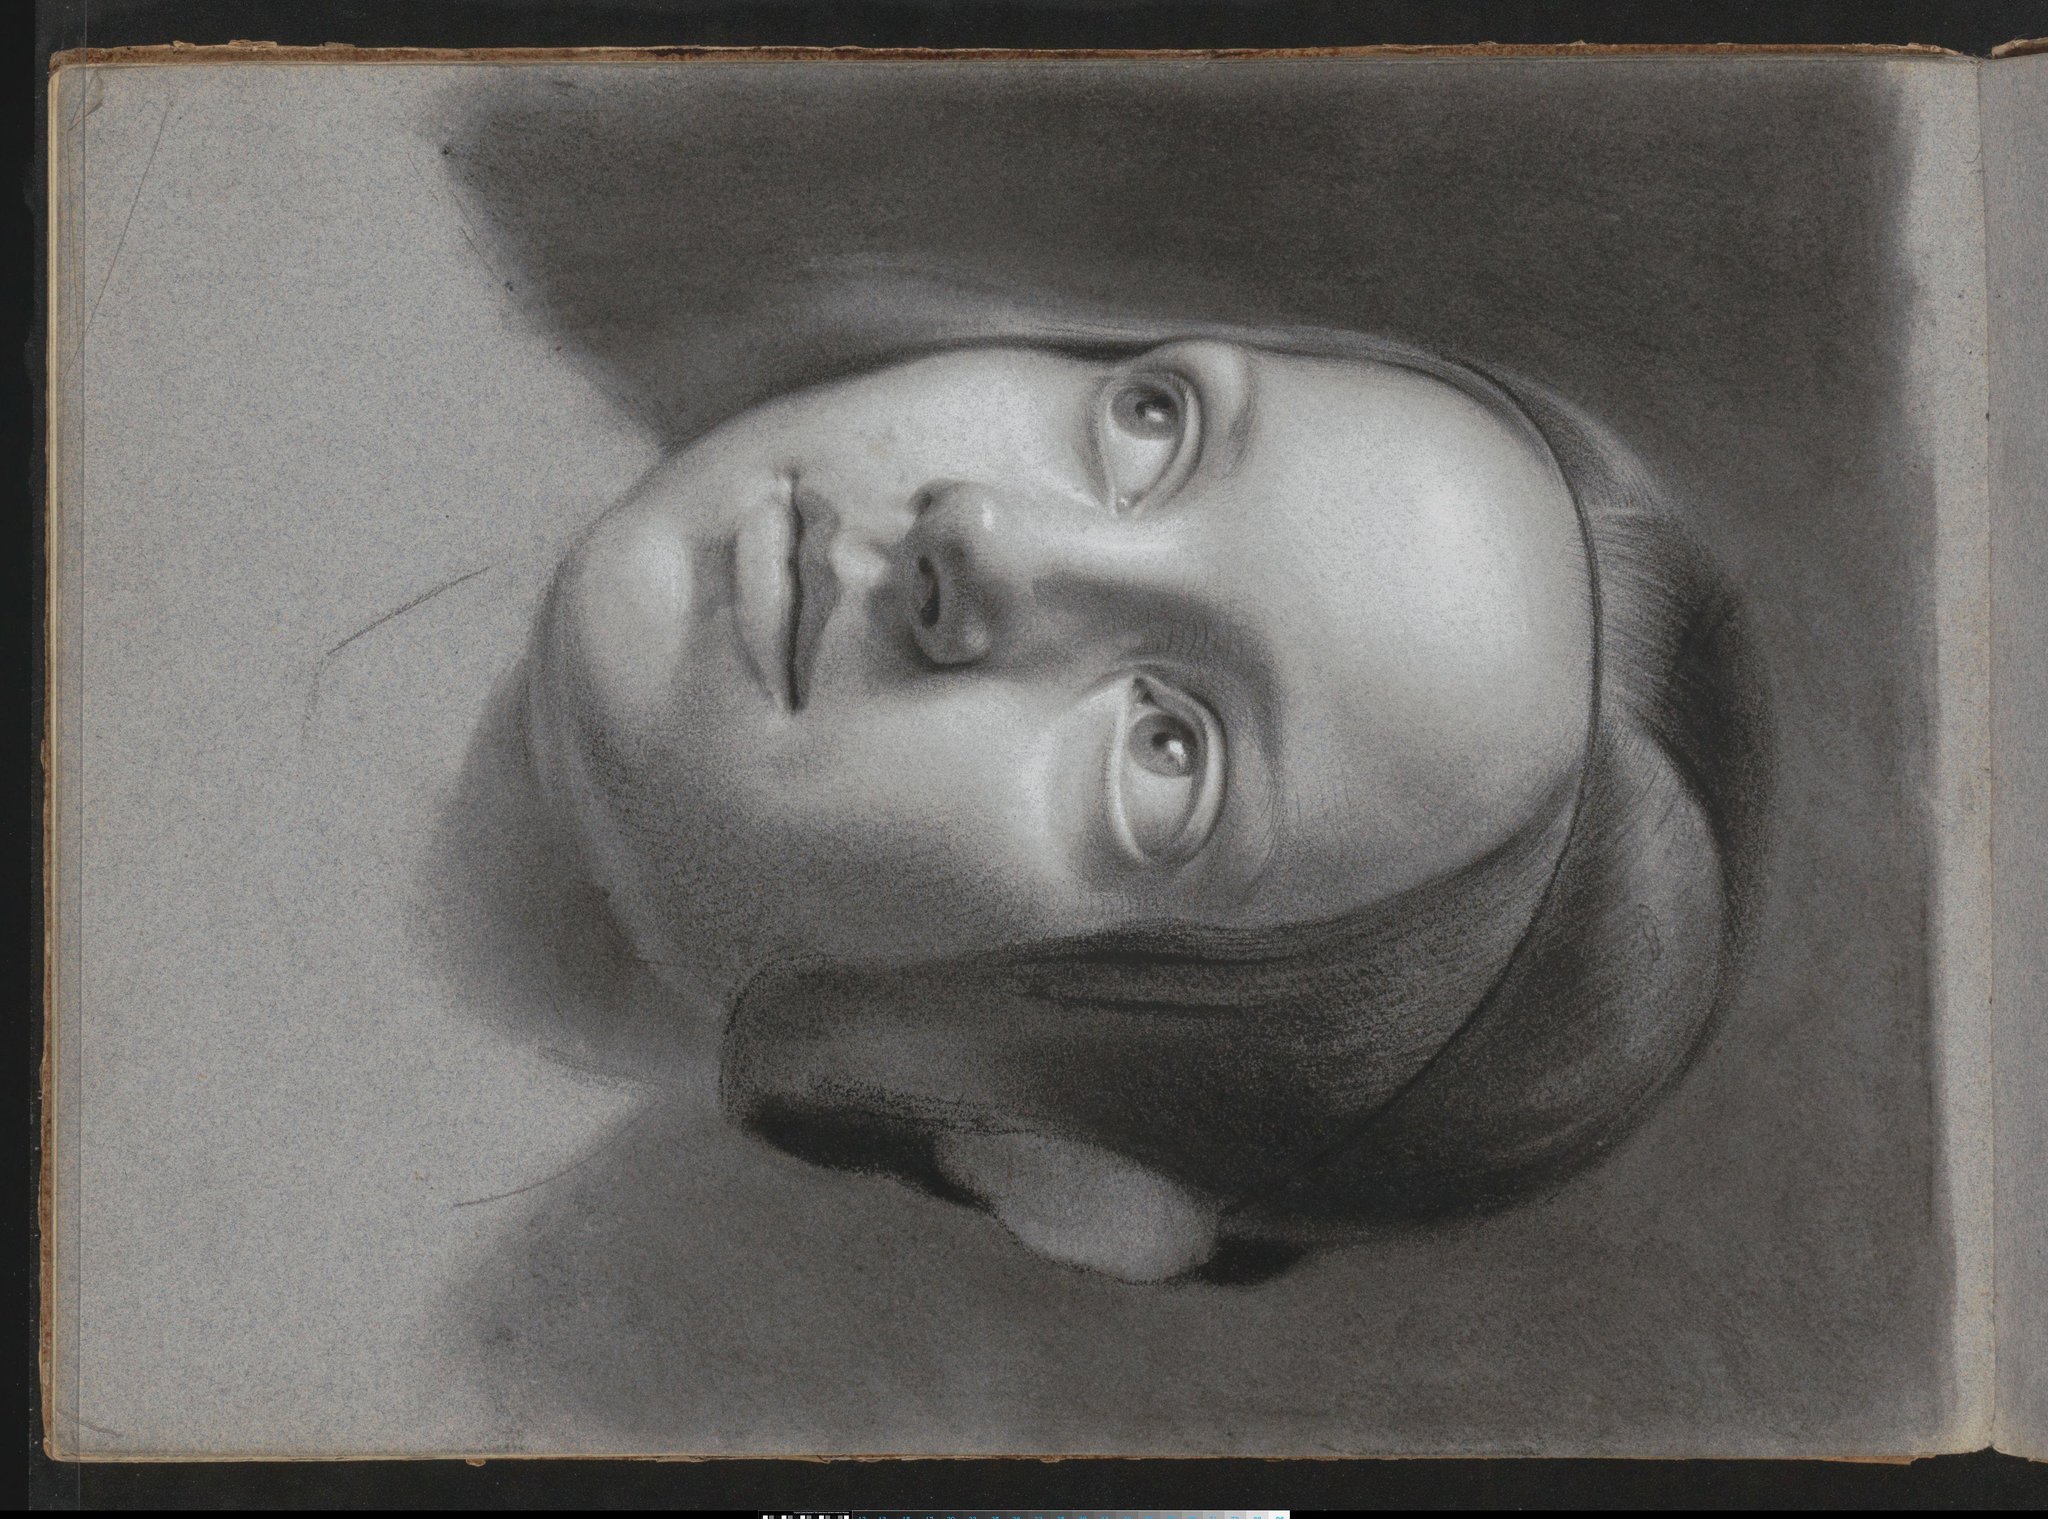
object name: sketchbook leaf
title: Portret van een jonge vrouw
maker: s. altmann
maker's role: painter, print maker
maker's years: 1822-1890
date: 1803-1840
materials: chalk, paper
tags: anonymous historical person portrayed, head (human) - aa - female human figure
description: Blad 19 verso uit een schetsboek met 24 bladen.